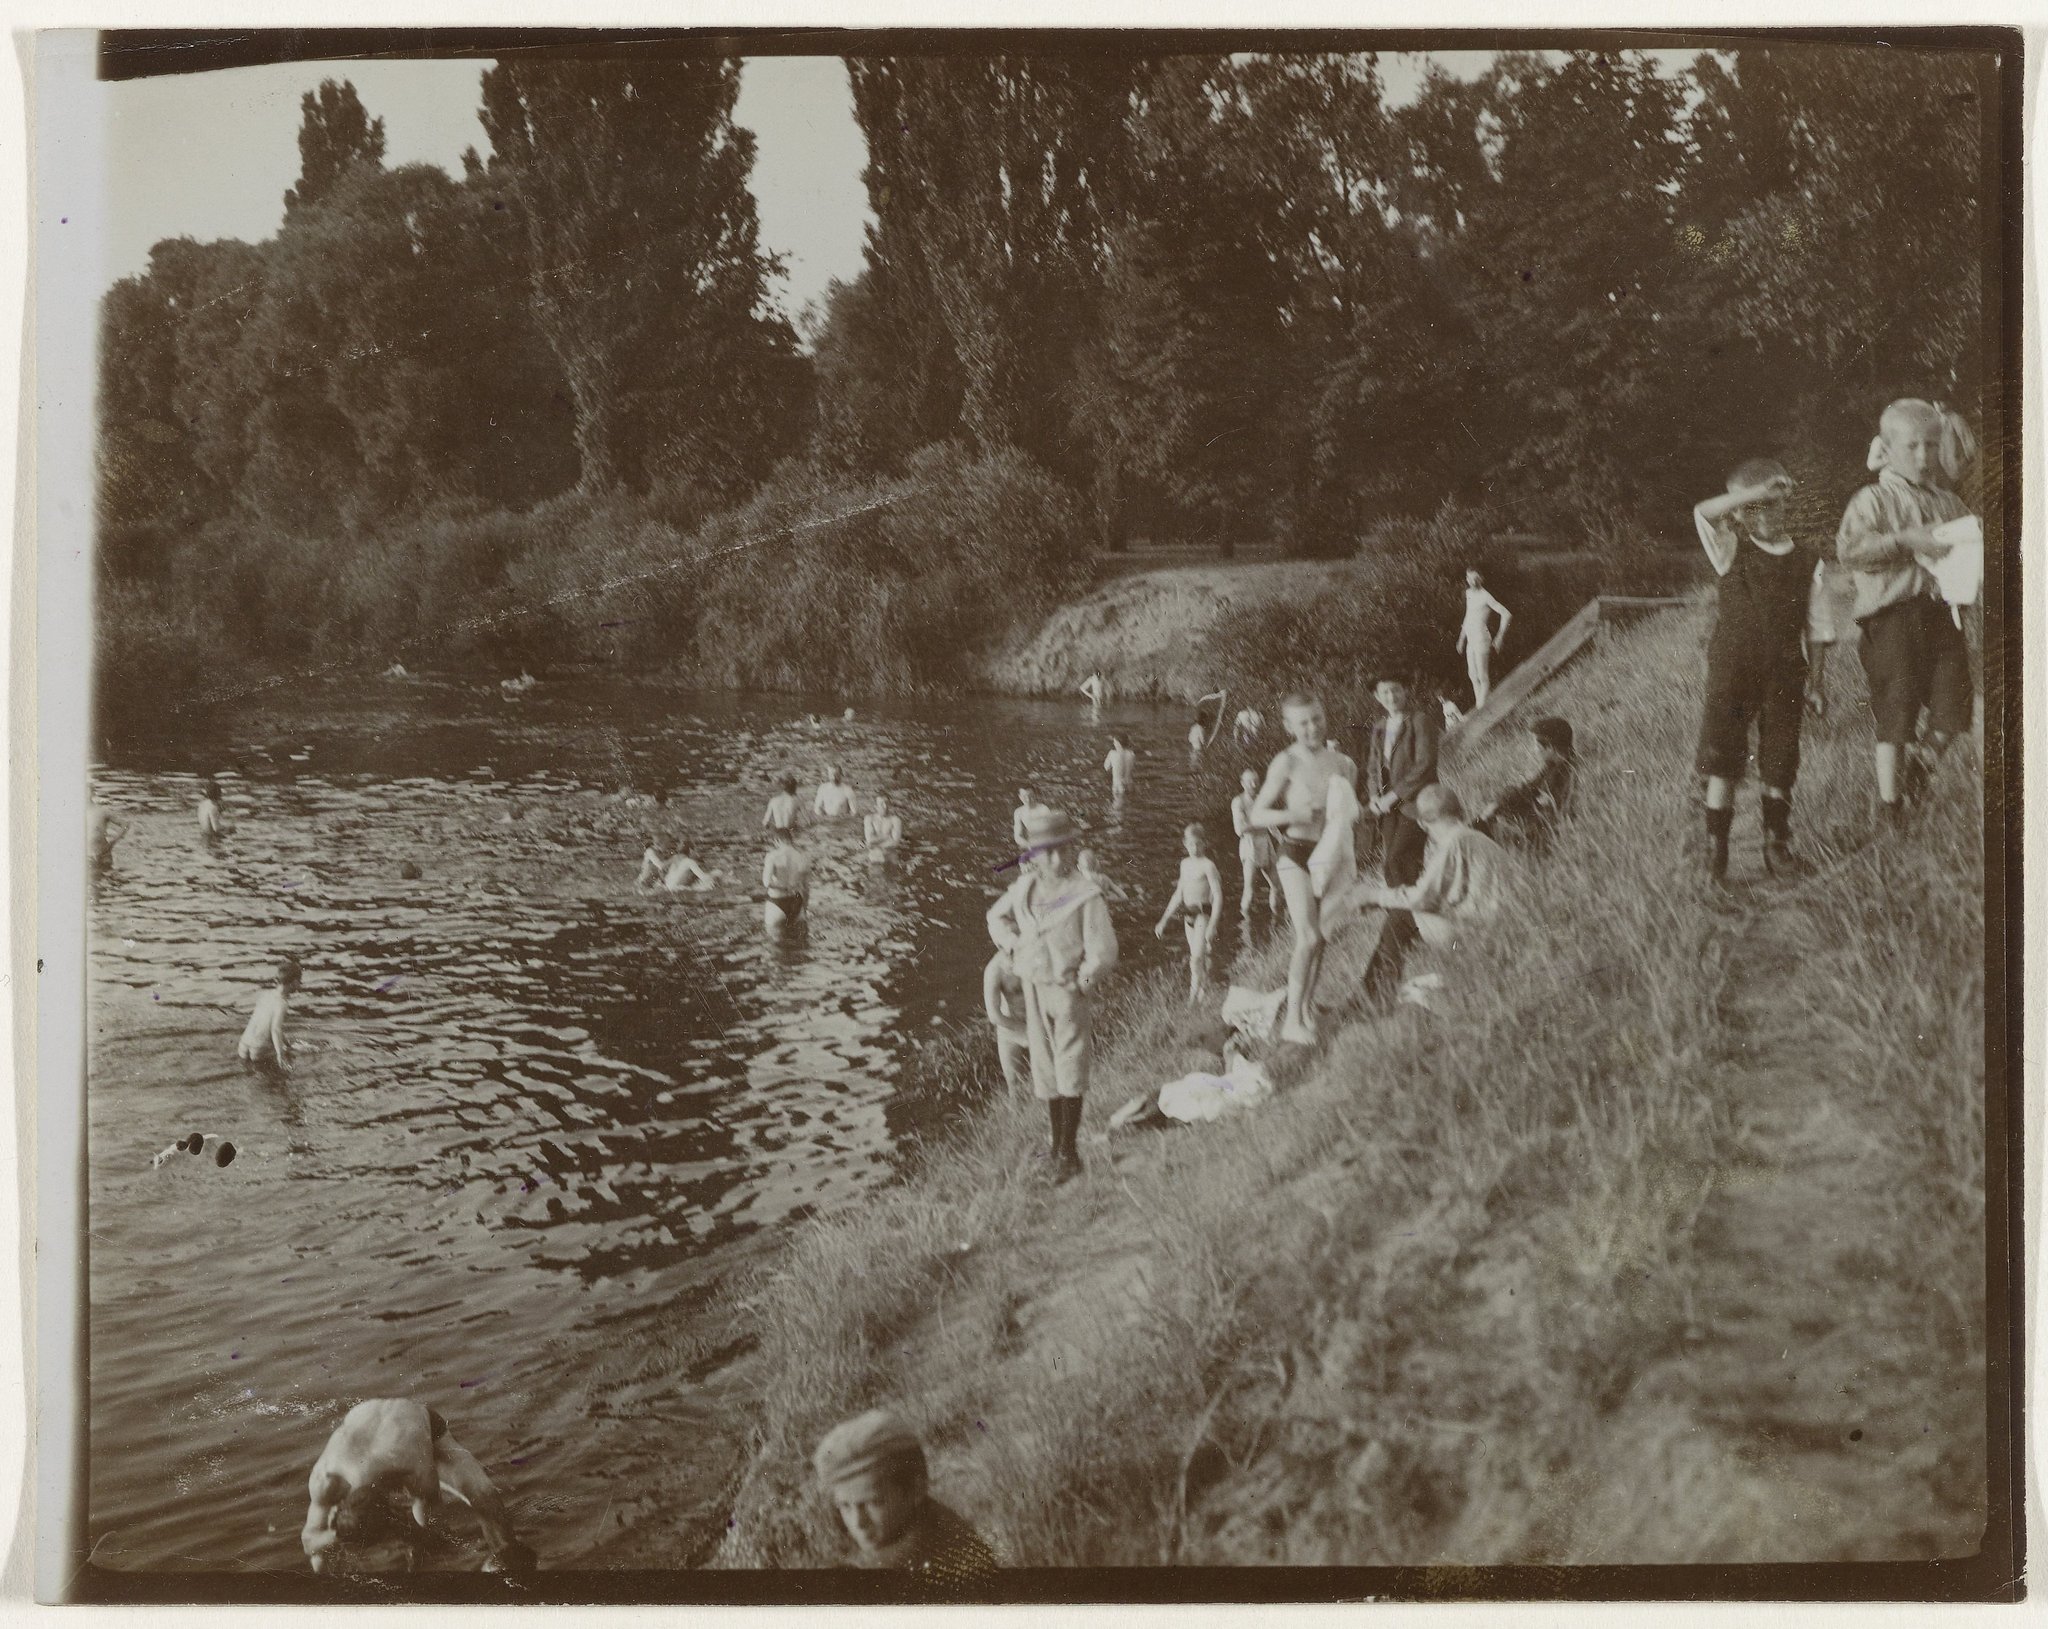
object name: photograph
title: Zwemmende mensen in een rivier, en kinderen op de oever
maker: Anonymous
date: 1900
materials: paper, photographic support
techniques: collodion silver print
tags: swimming (sport), river (+ landscape with figures, staffage)